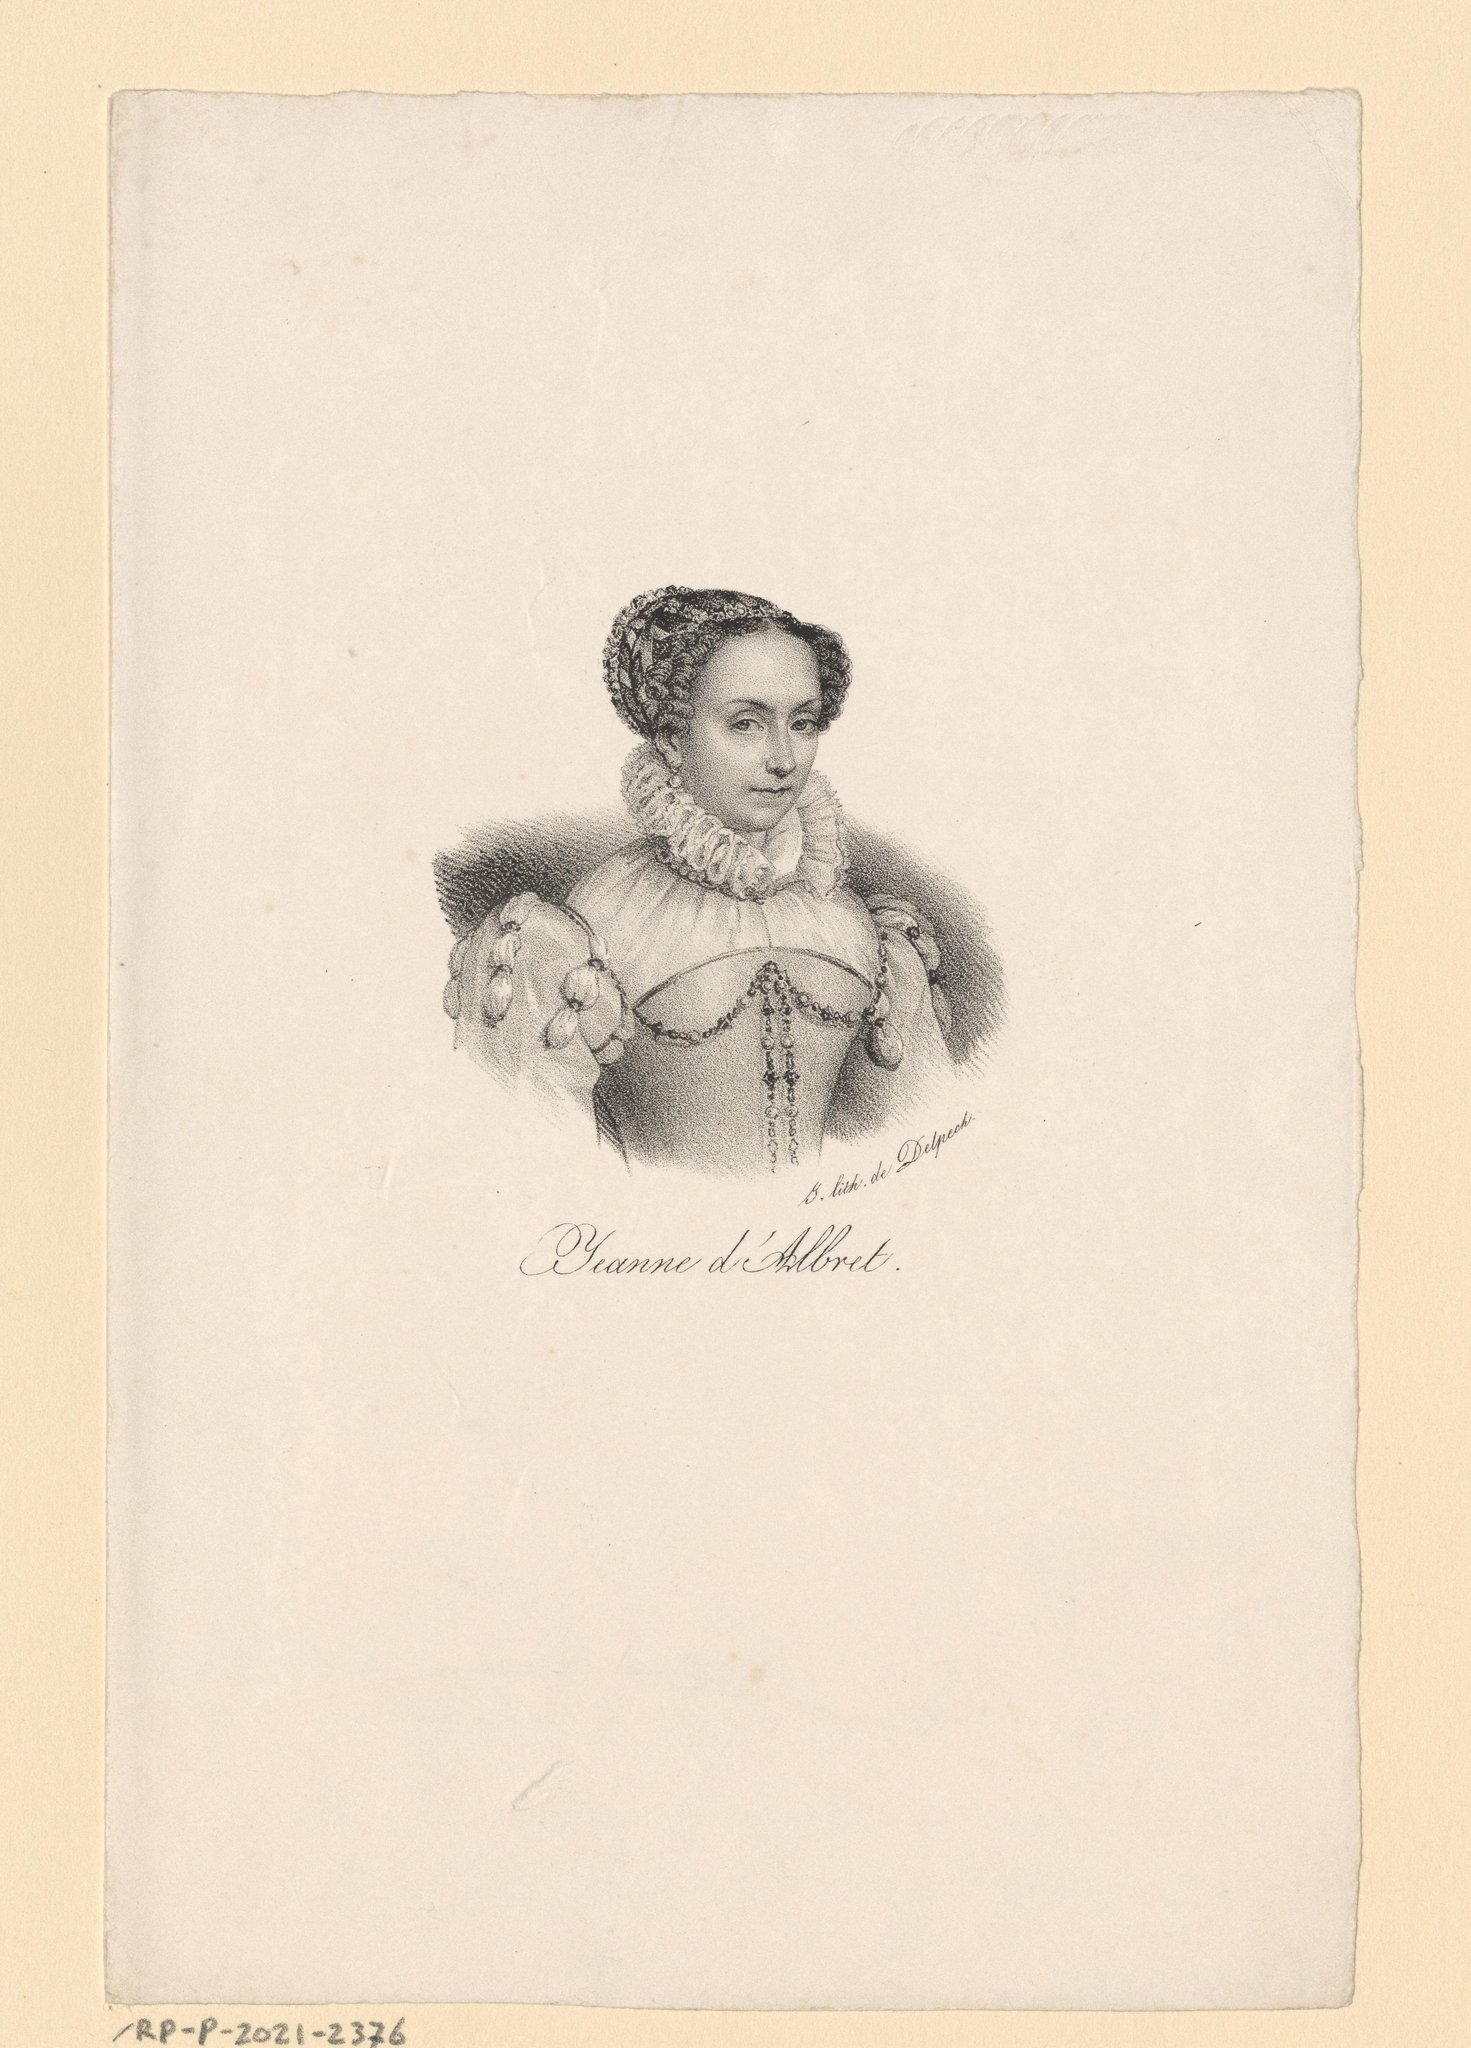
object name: print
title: Portret van Johanna van Albret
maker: Anonymous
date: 1818-1842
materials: paper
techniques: lithograph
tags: paris, historical persons - bb - woman, queen